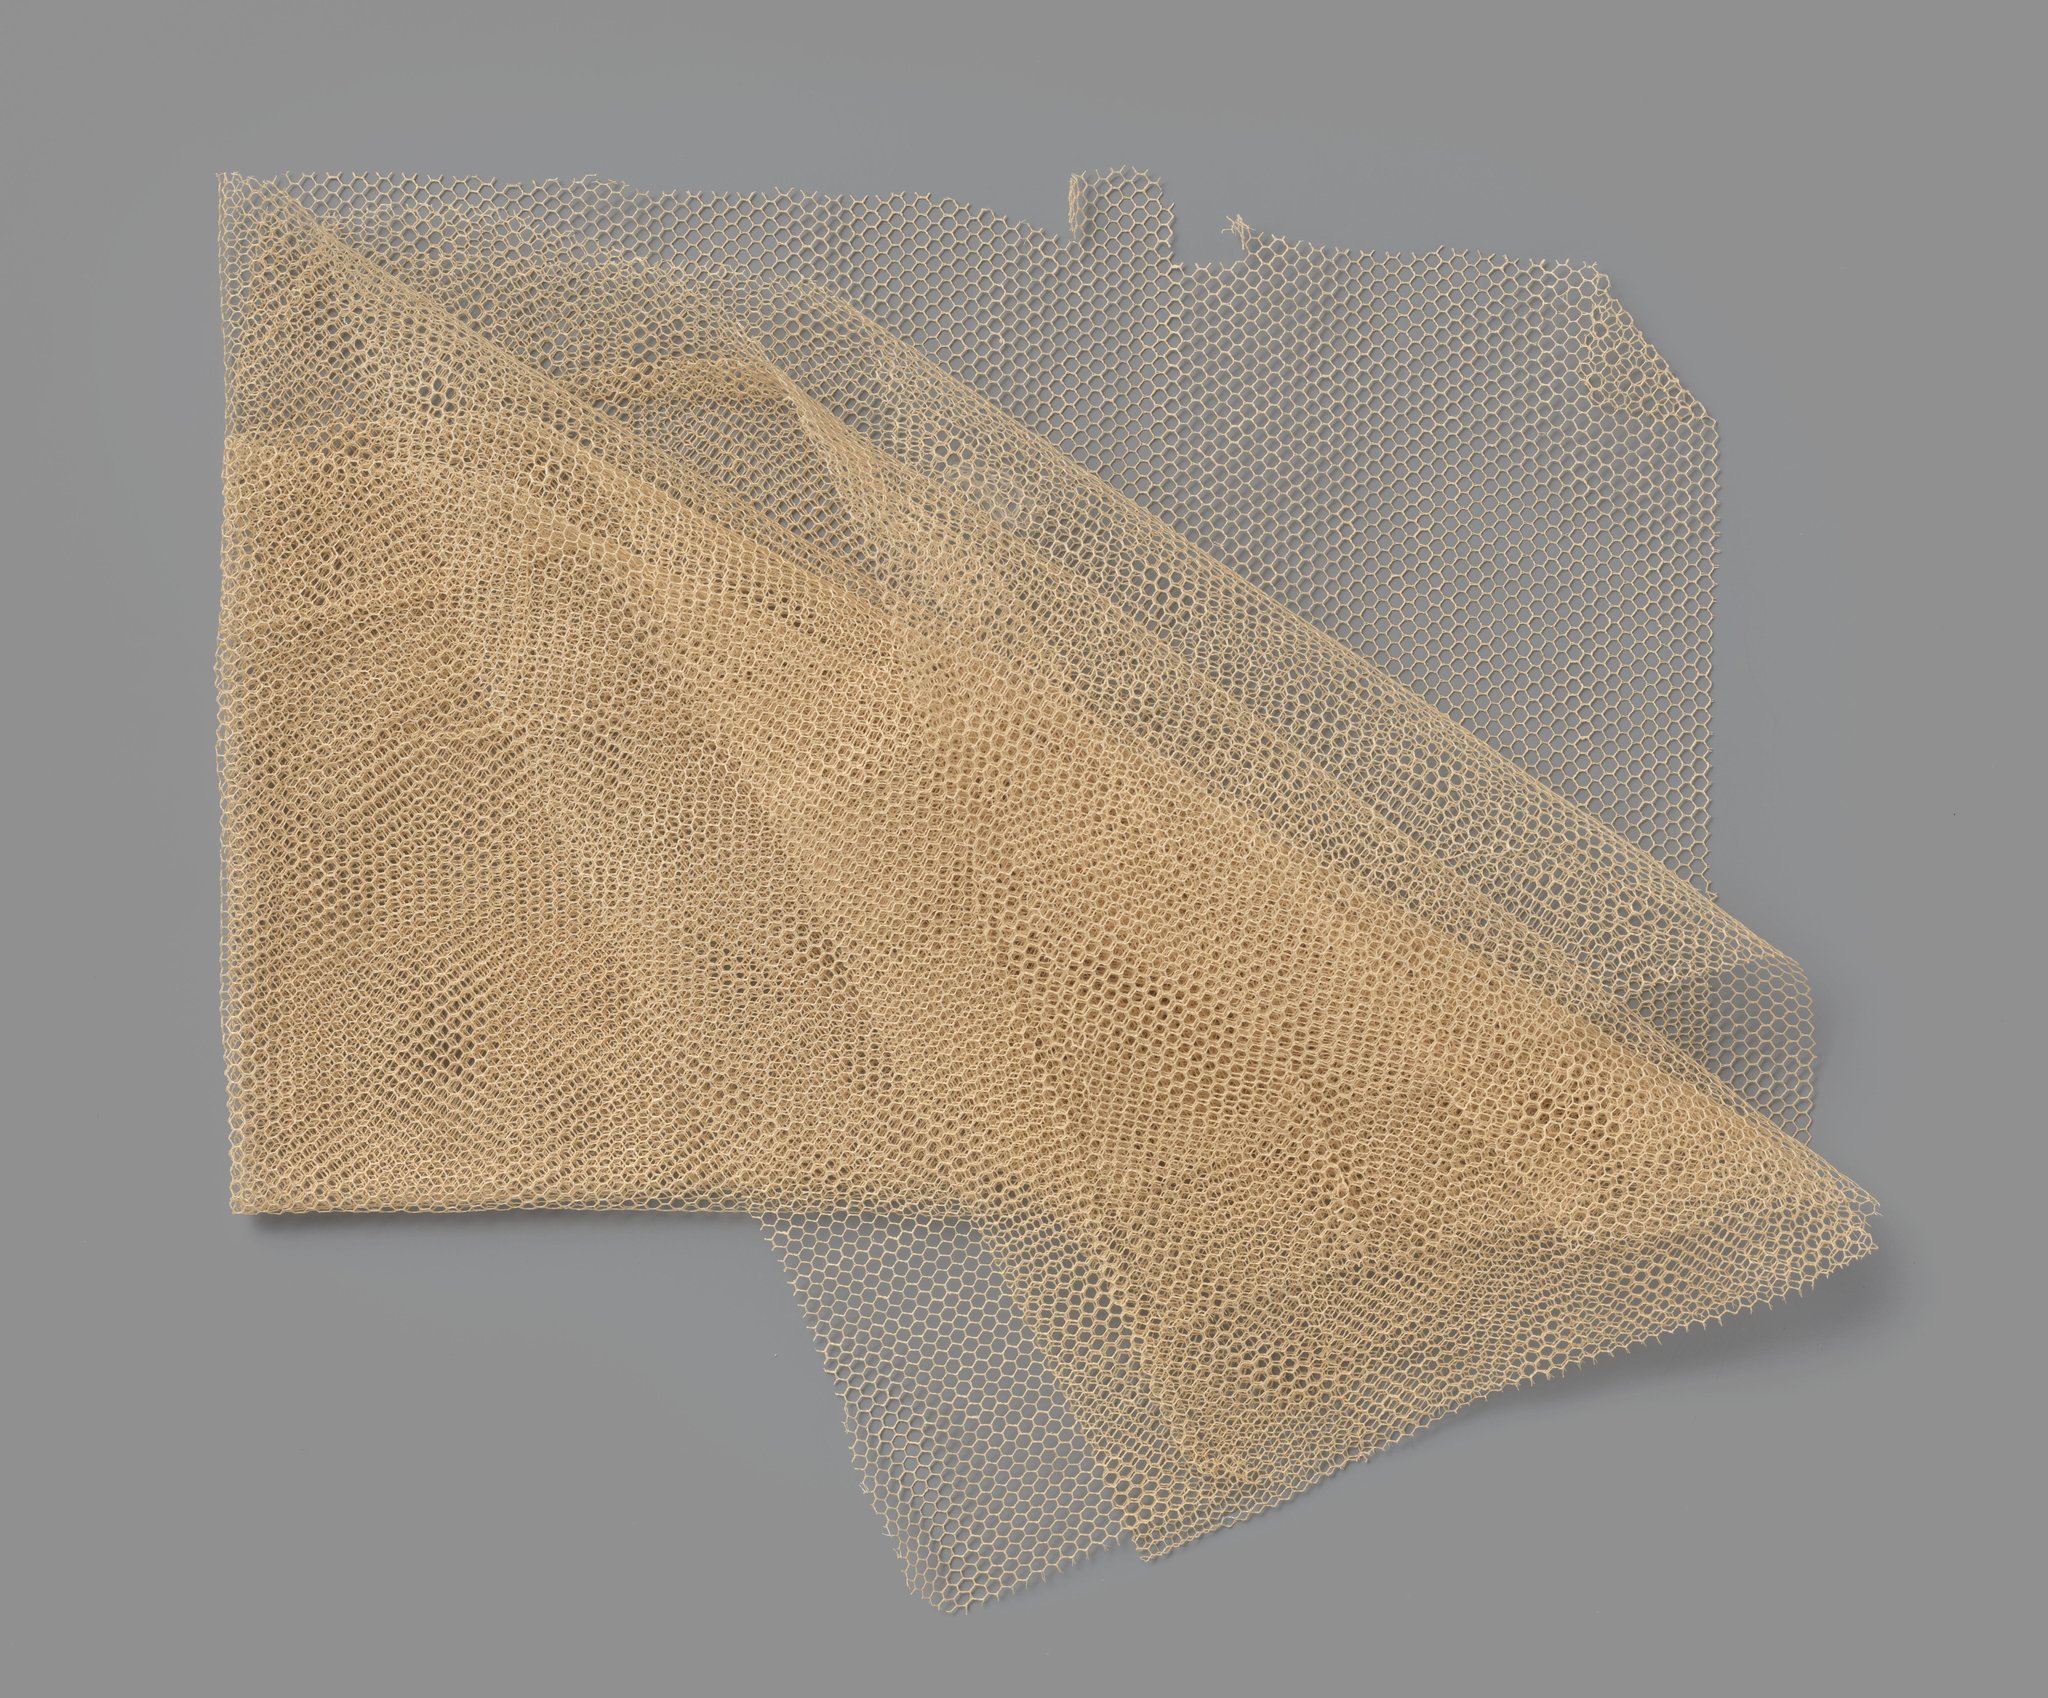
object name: coupon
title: Fragment crème-witte grove katoenen tule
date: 1900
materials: cotton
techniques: weave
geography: nijmegen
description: Fragment crème-witte grove katoenen tule.